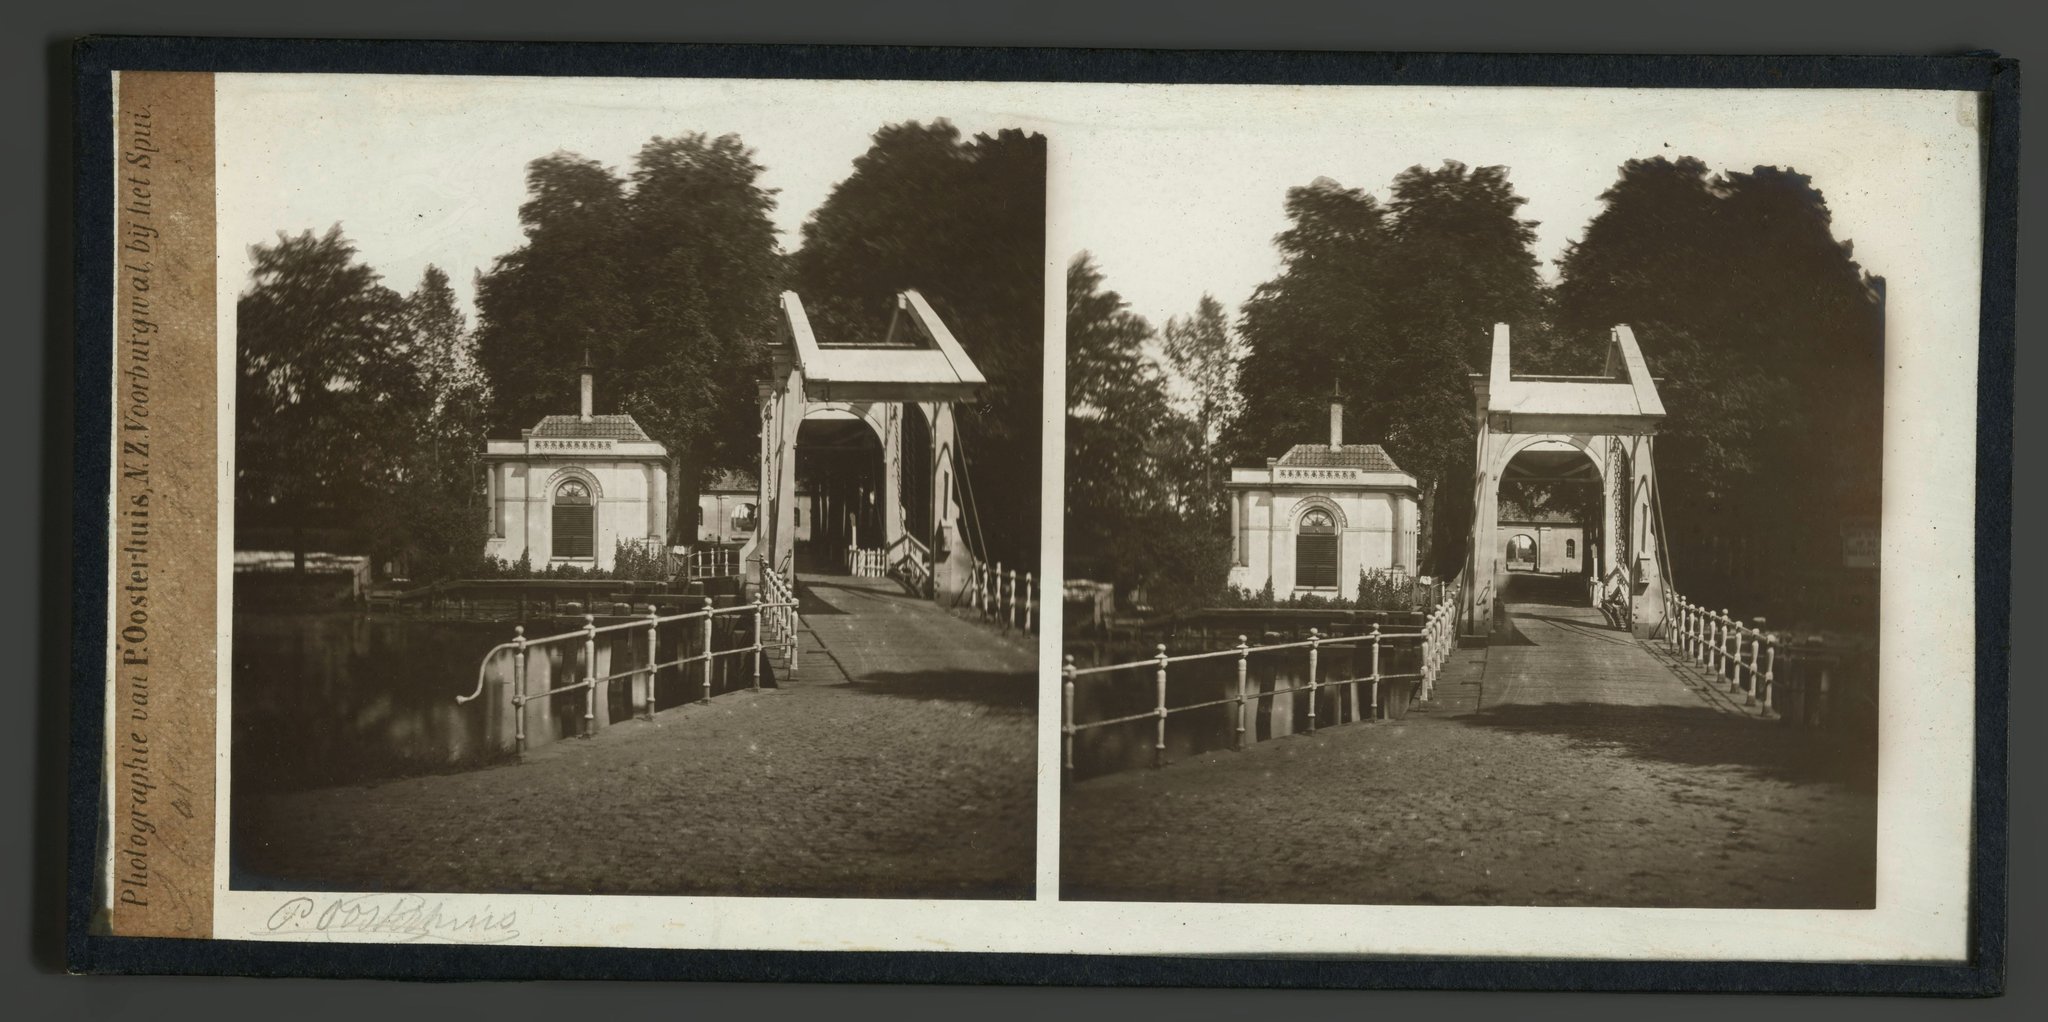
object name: stereoscopic photograph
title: Gezicht op 's Gravelandsche poort te Weesp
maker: pieter oosterhuis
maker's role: draughtsman, print maker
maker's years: 1816-1885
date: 1856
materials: glass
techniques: slide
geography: weesp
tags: bridge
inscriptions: address: ‘N.Z. Voorburgwal, bij het Spui.’